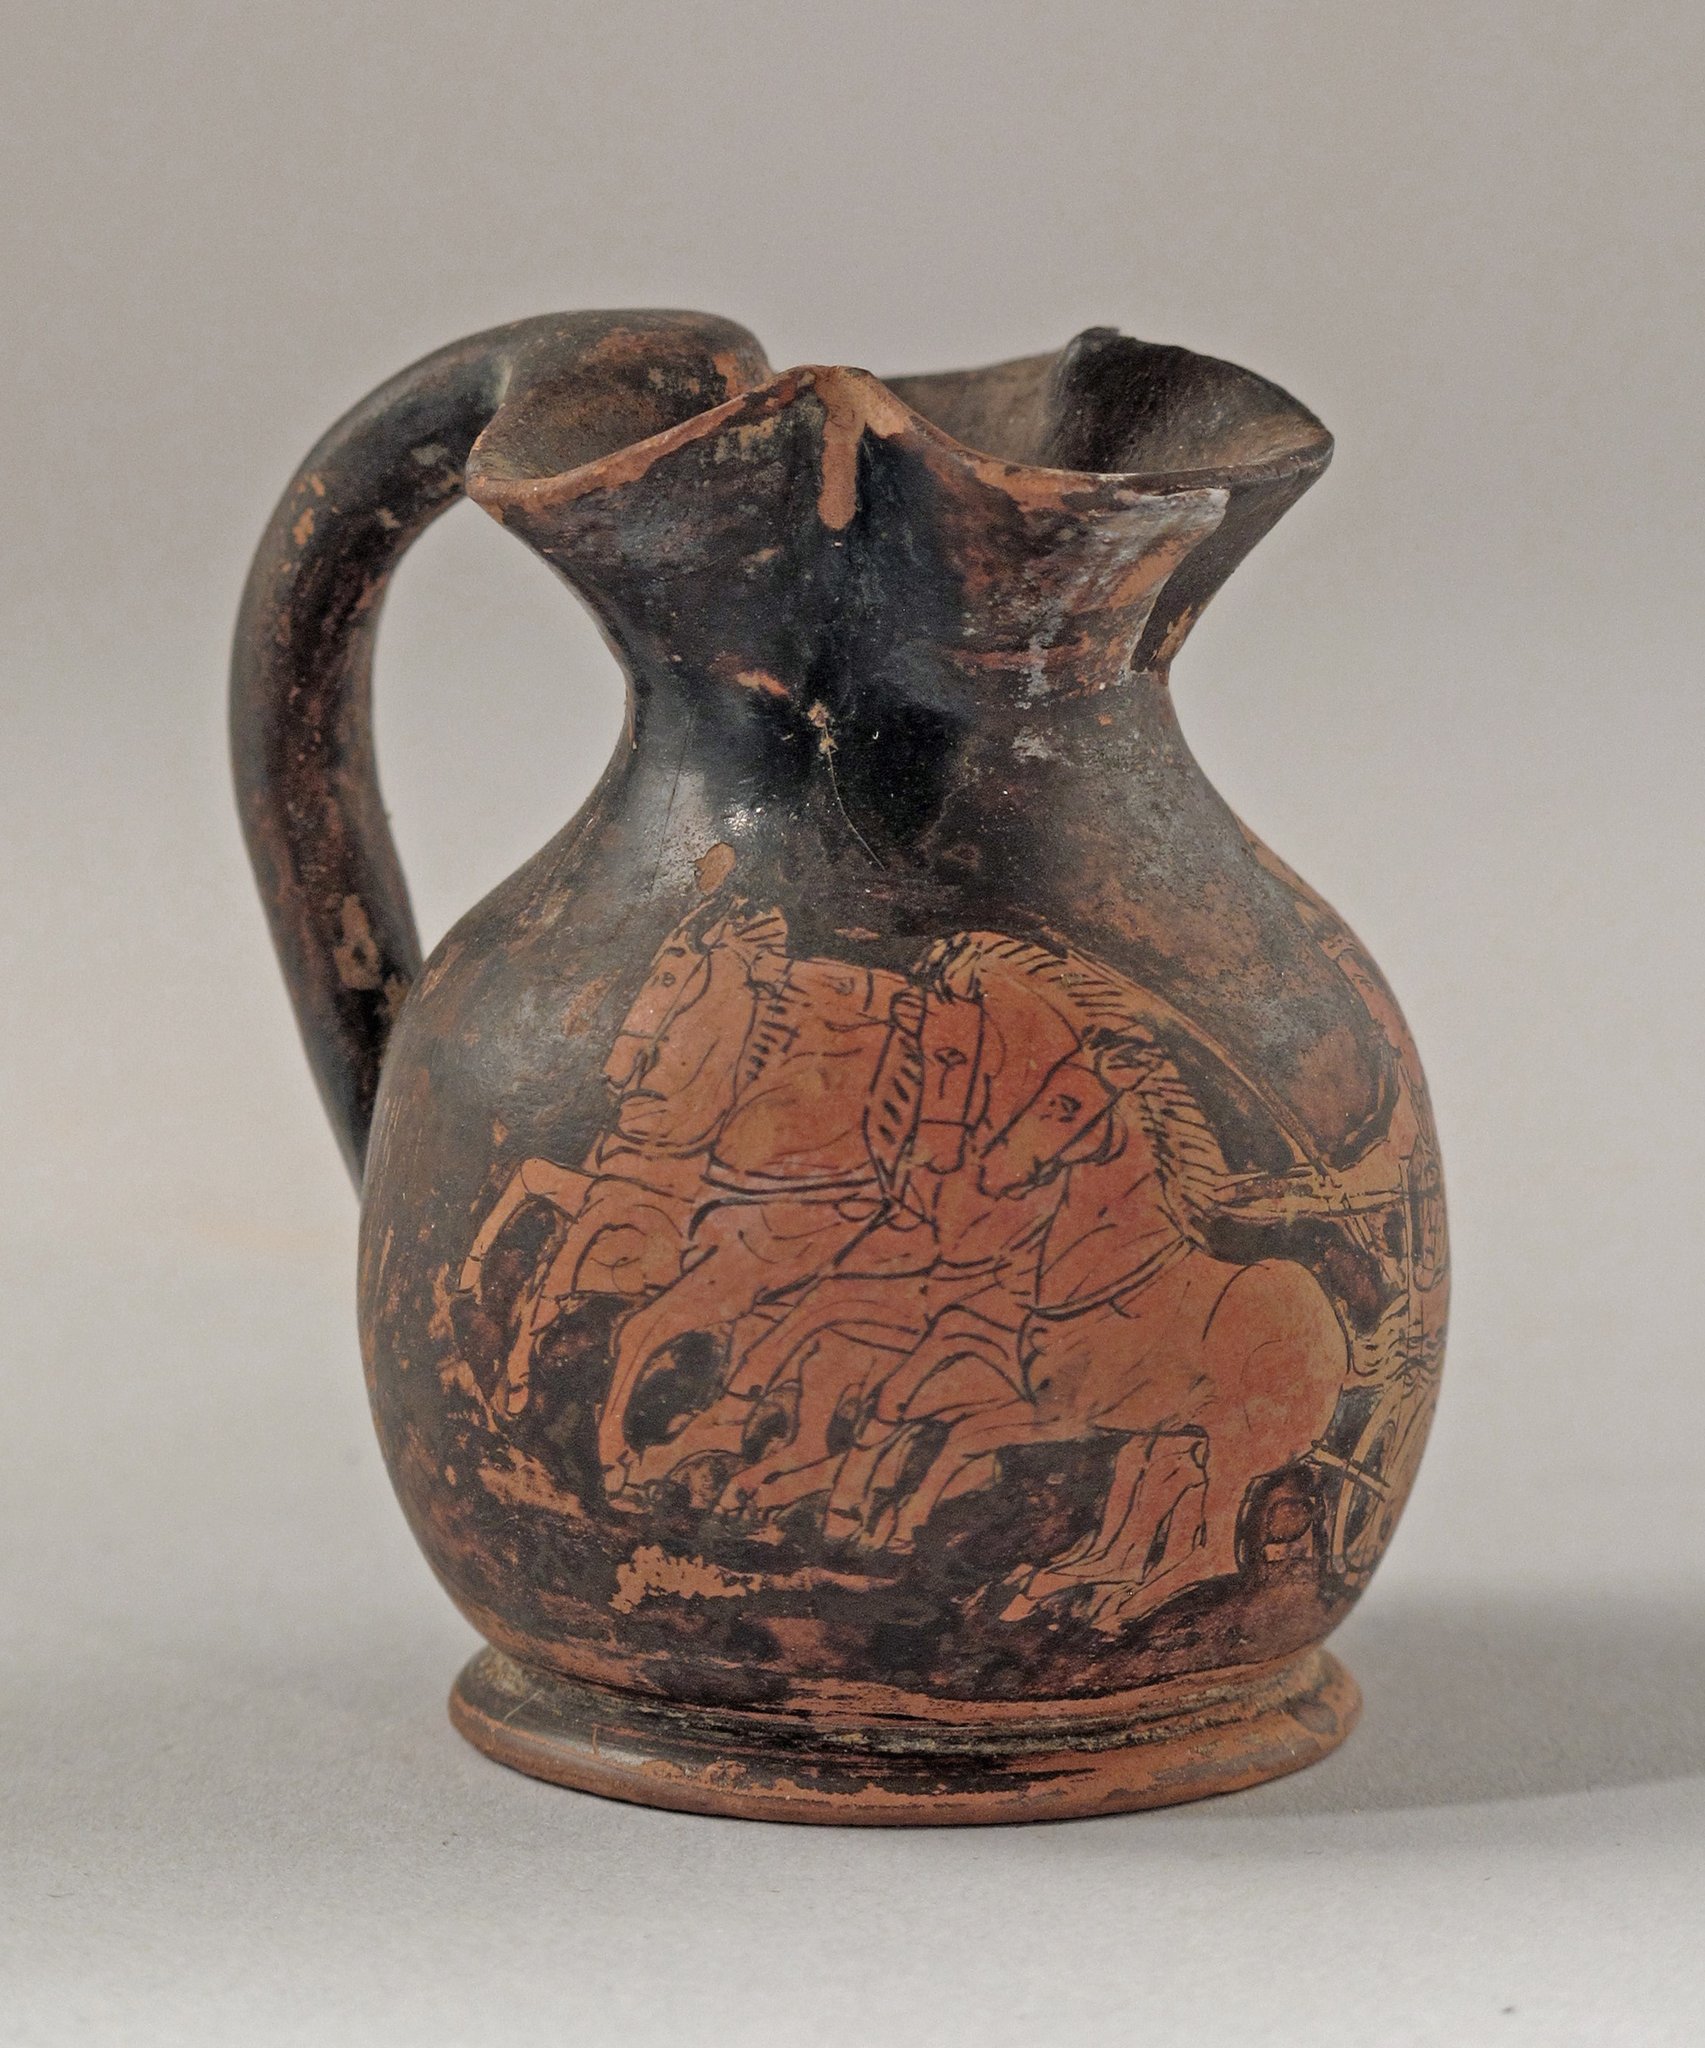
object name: oinochoe, miniature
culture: greek, attic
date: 400-368 BCE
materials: terracotta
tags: men,horses,chariots